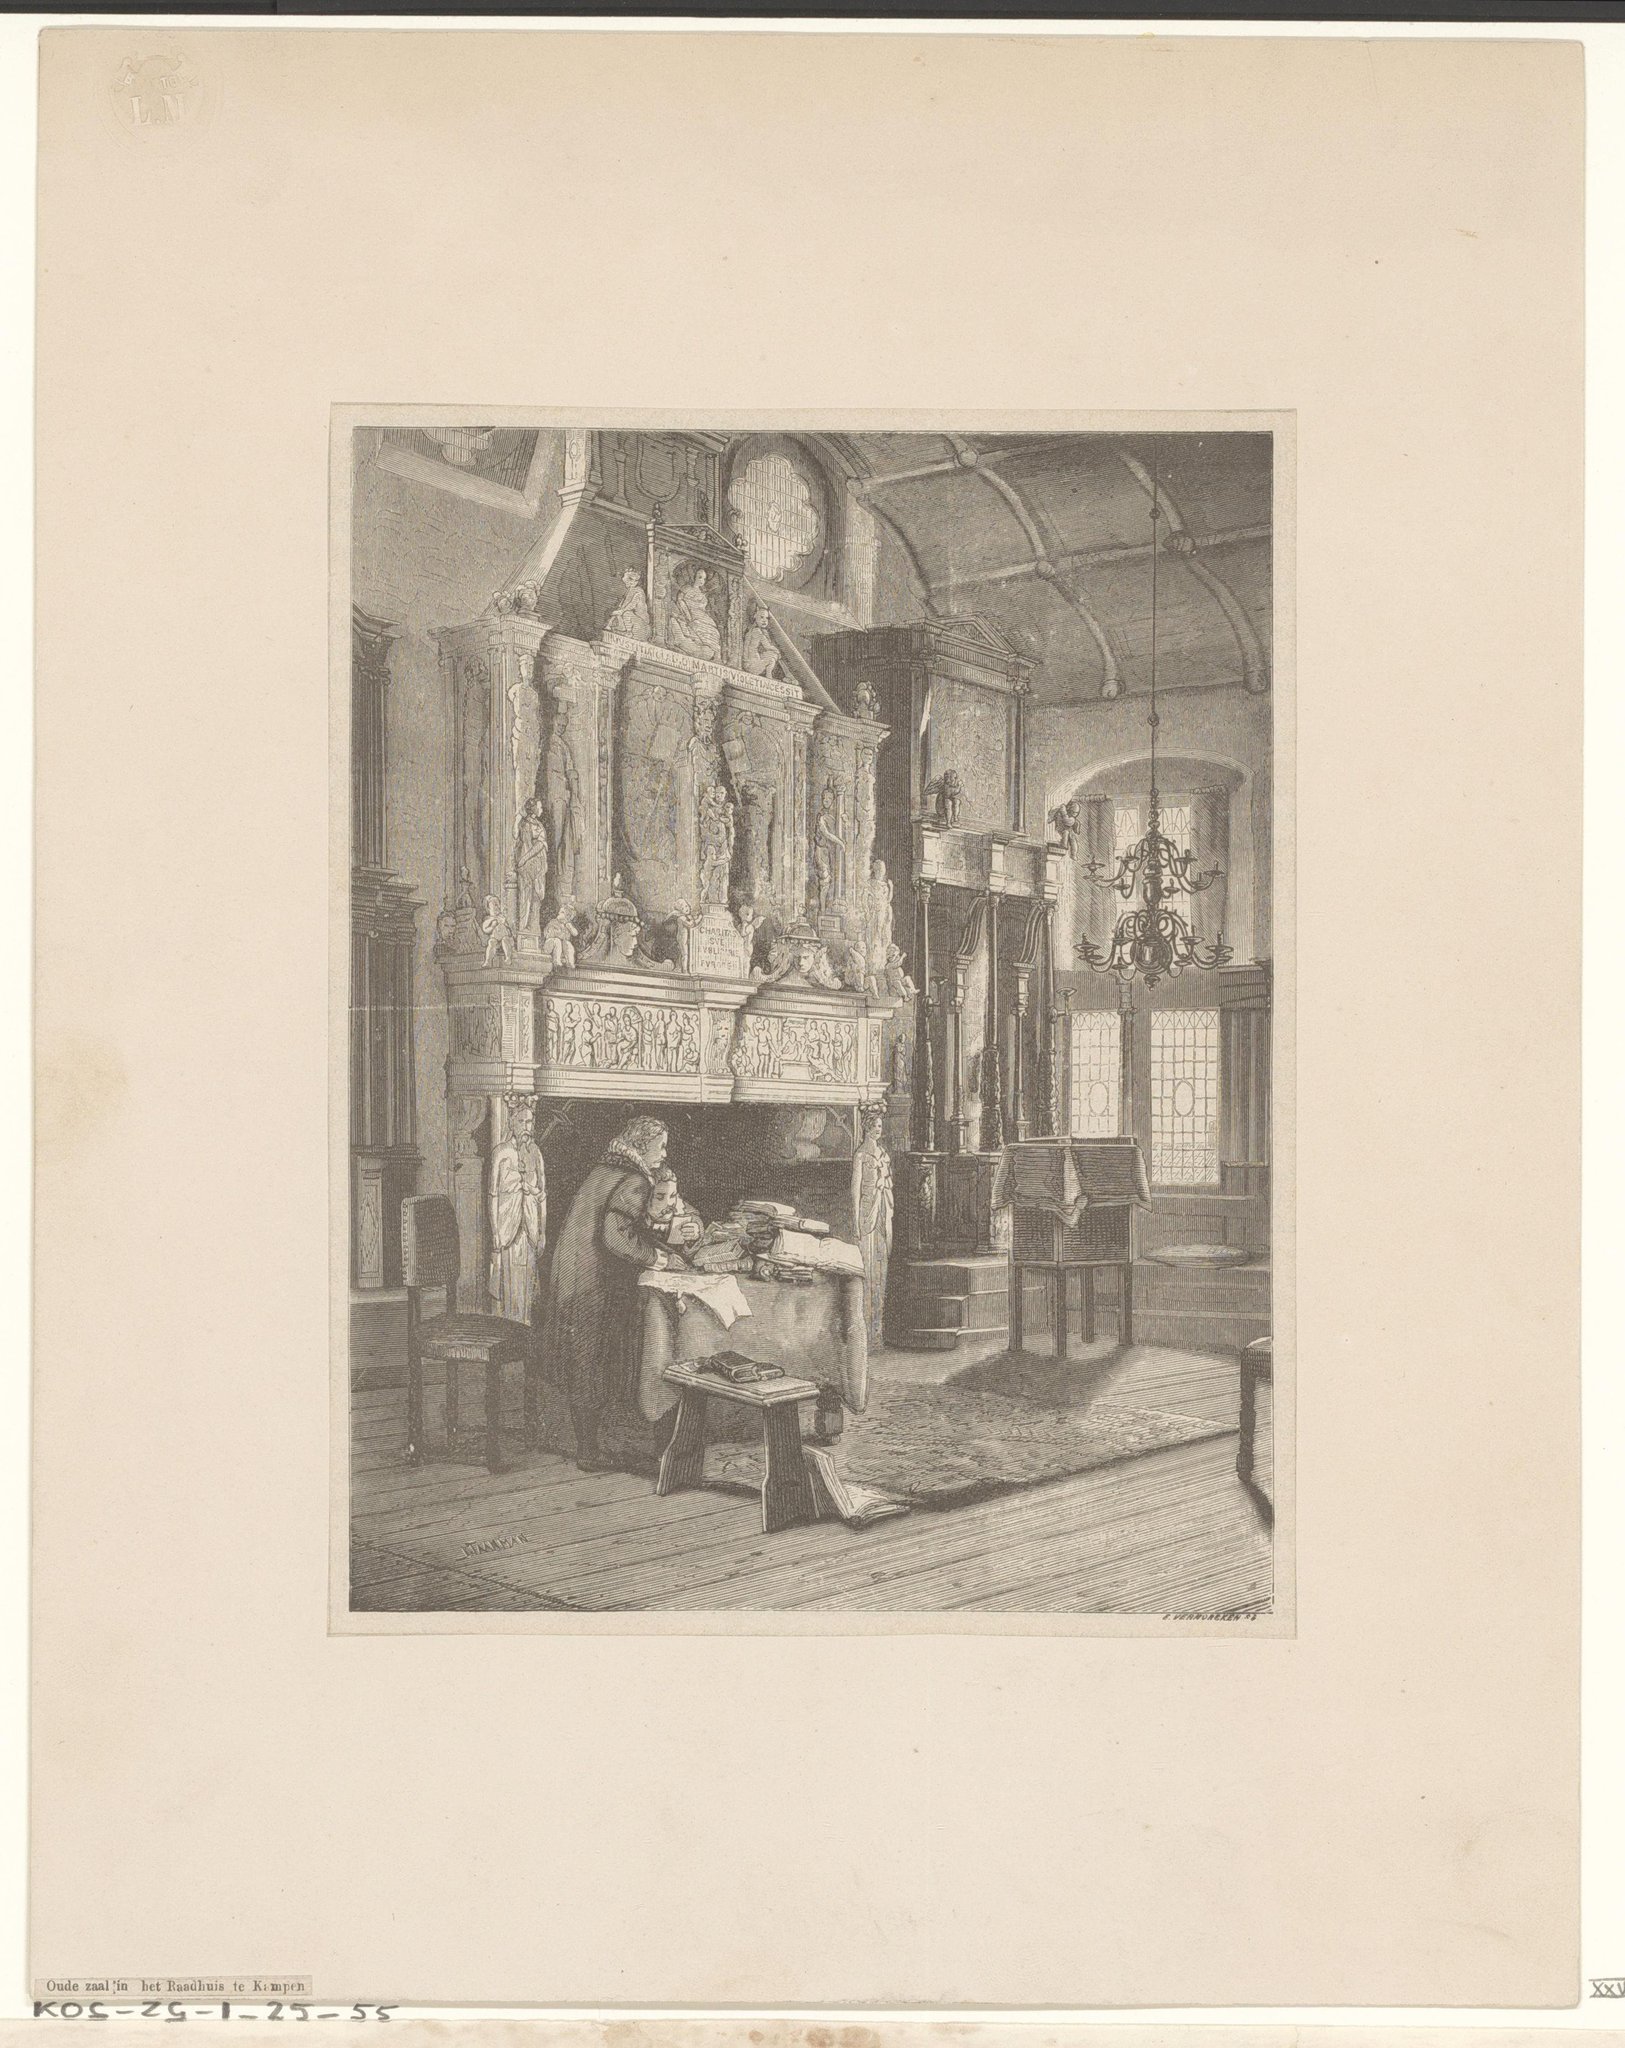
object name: print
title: Schepenzaal in het stadhuis te Kampen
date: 1878-1906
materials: paper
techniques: engraving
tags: townhall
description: Onderwerpsrubrieken binnen de Atlas Zeden en Gewoonten: Zeden en Gewoonten in Engeren Zin, De Woning, Binnenhuizen, Schoorsteenen.